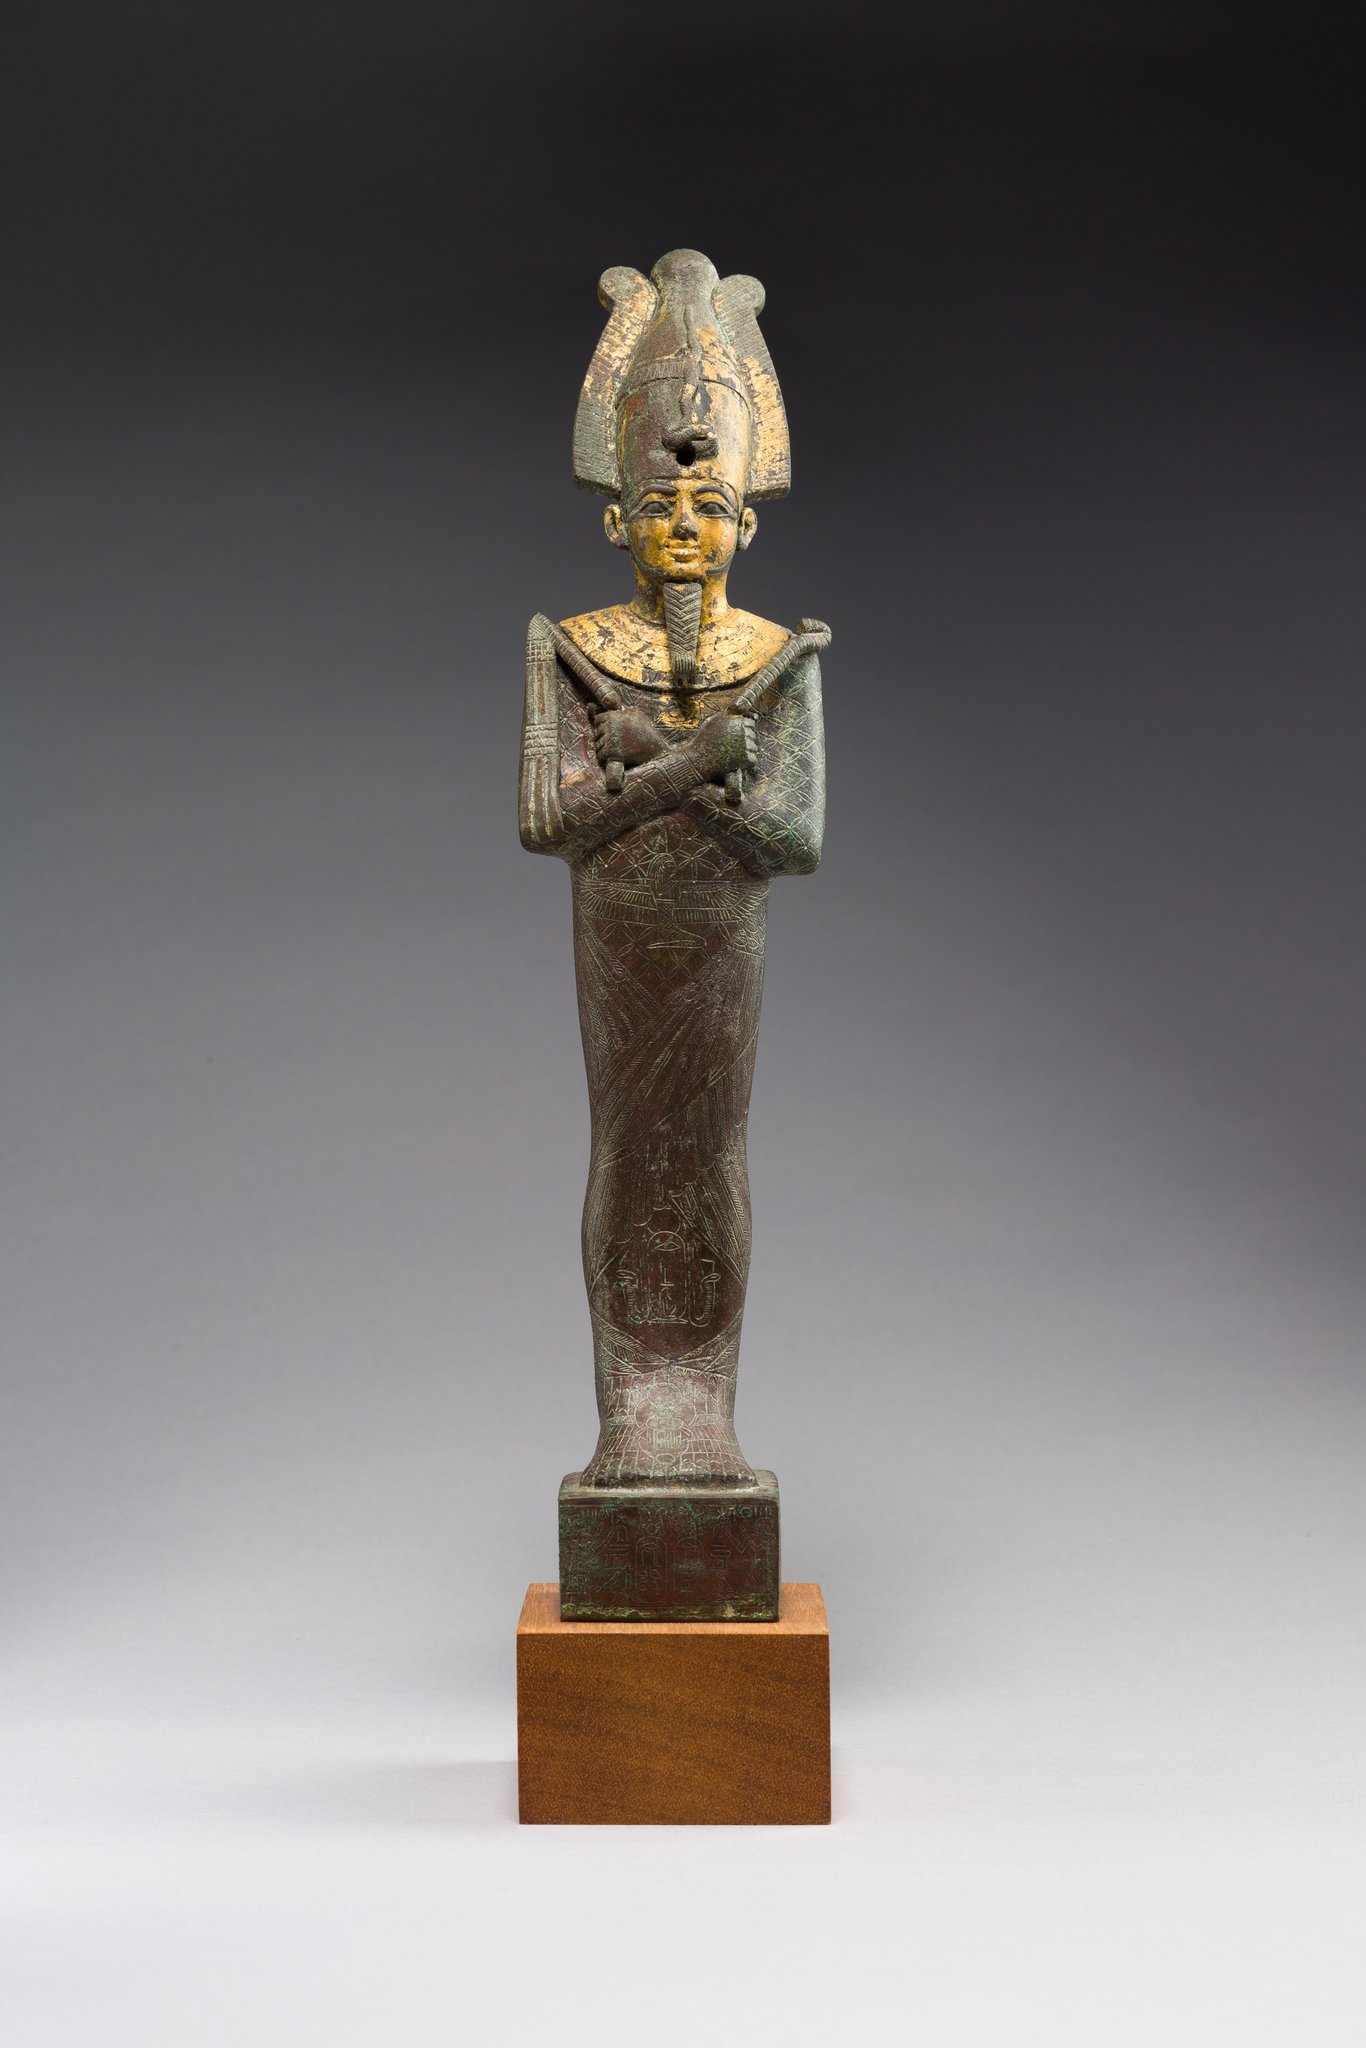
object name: statuette, osiris, padihorpere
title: Statuette of Osiris with the epithets Neb Ankh and Khentyimentiu, donated by Padihorpare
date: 588-526 BCE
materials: metal, gold leaf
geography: egypt